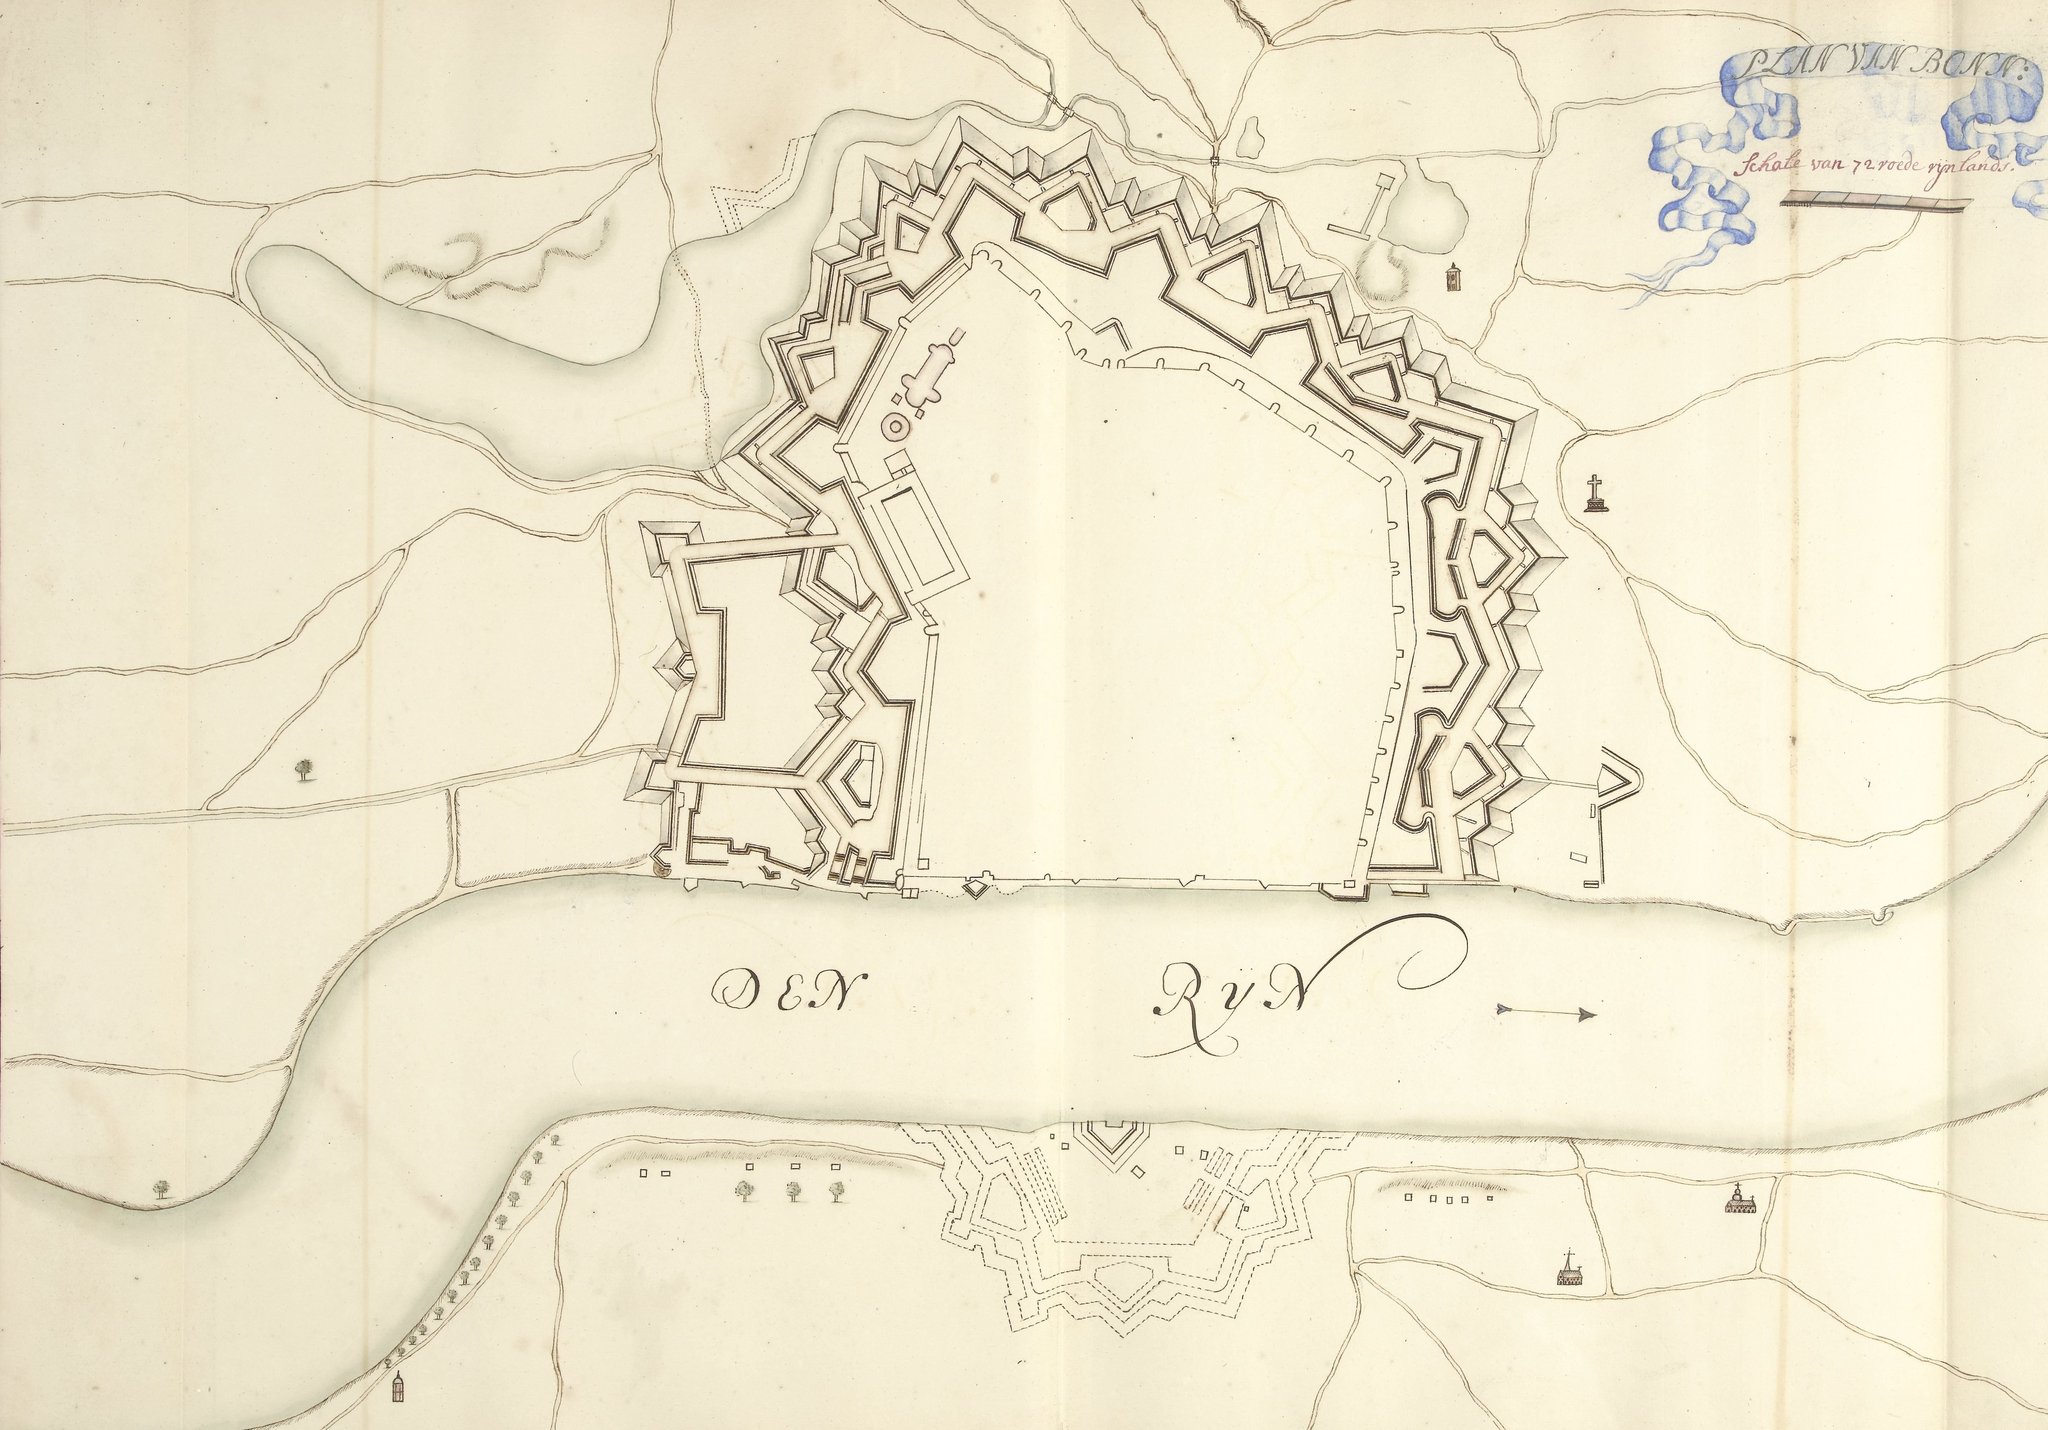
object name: map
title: Plan van Bonn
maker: samuel du ry de champdoré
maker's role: draughtsman, engineer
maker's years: 1651-1729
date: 1701-1715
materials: paper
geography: netherlands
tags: fortress, maps of cities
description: Plattegrond van de versterkingen om de stad Bonn, ca. 1701-1715. Linksonder de legenda A-G in het Frans. Onderdeel van een verzameling getekende plannen van versterkte plaatsen in Nederland en omringende landen ten tijde van de Spaanse Successieoorlog (deel B).